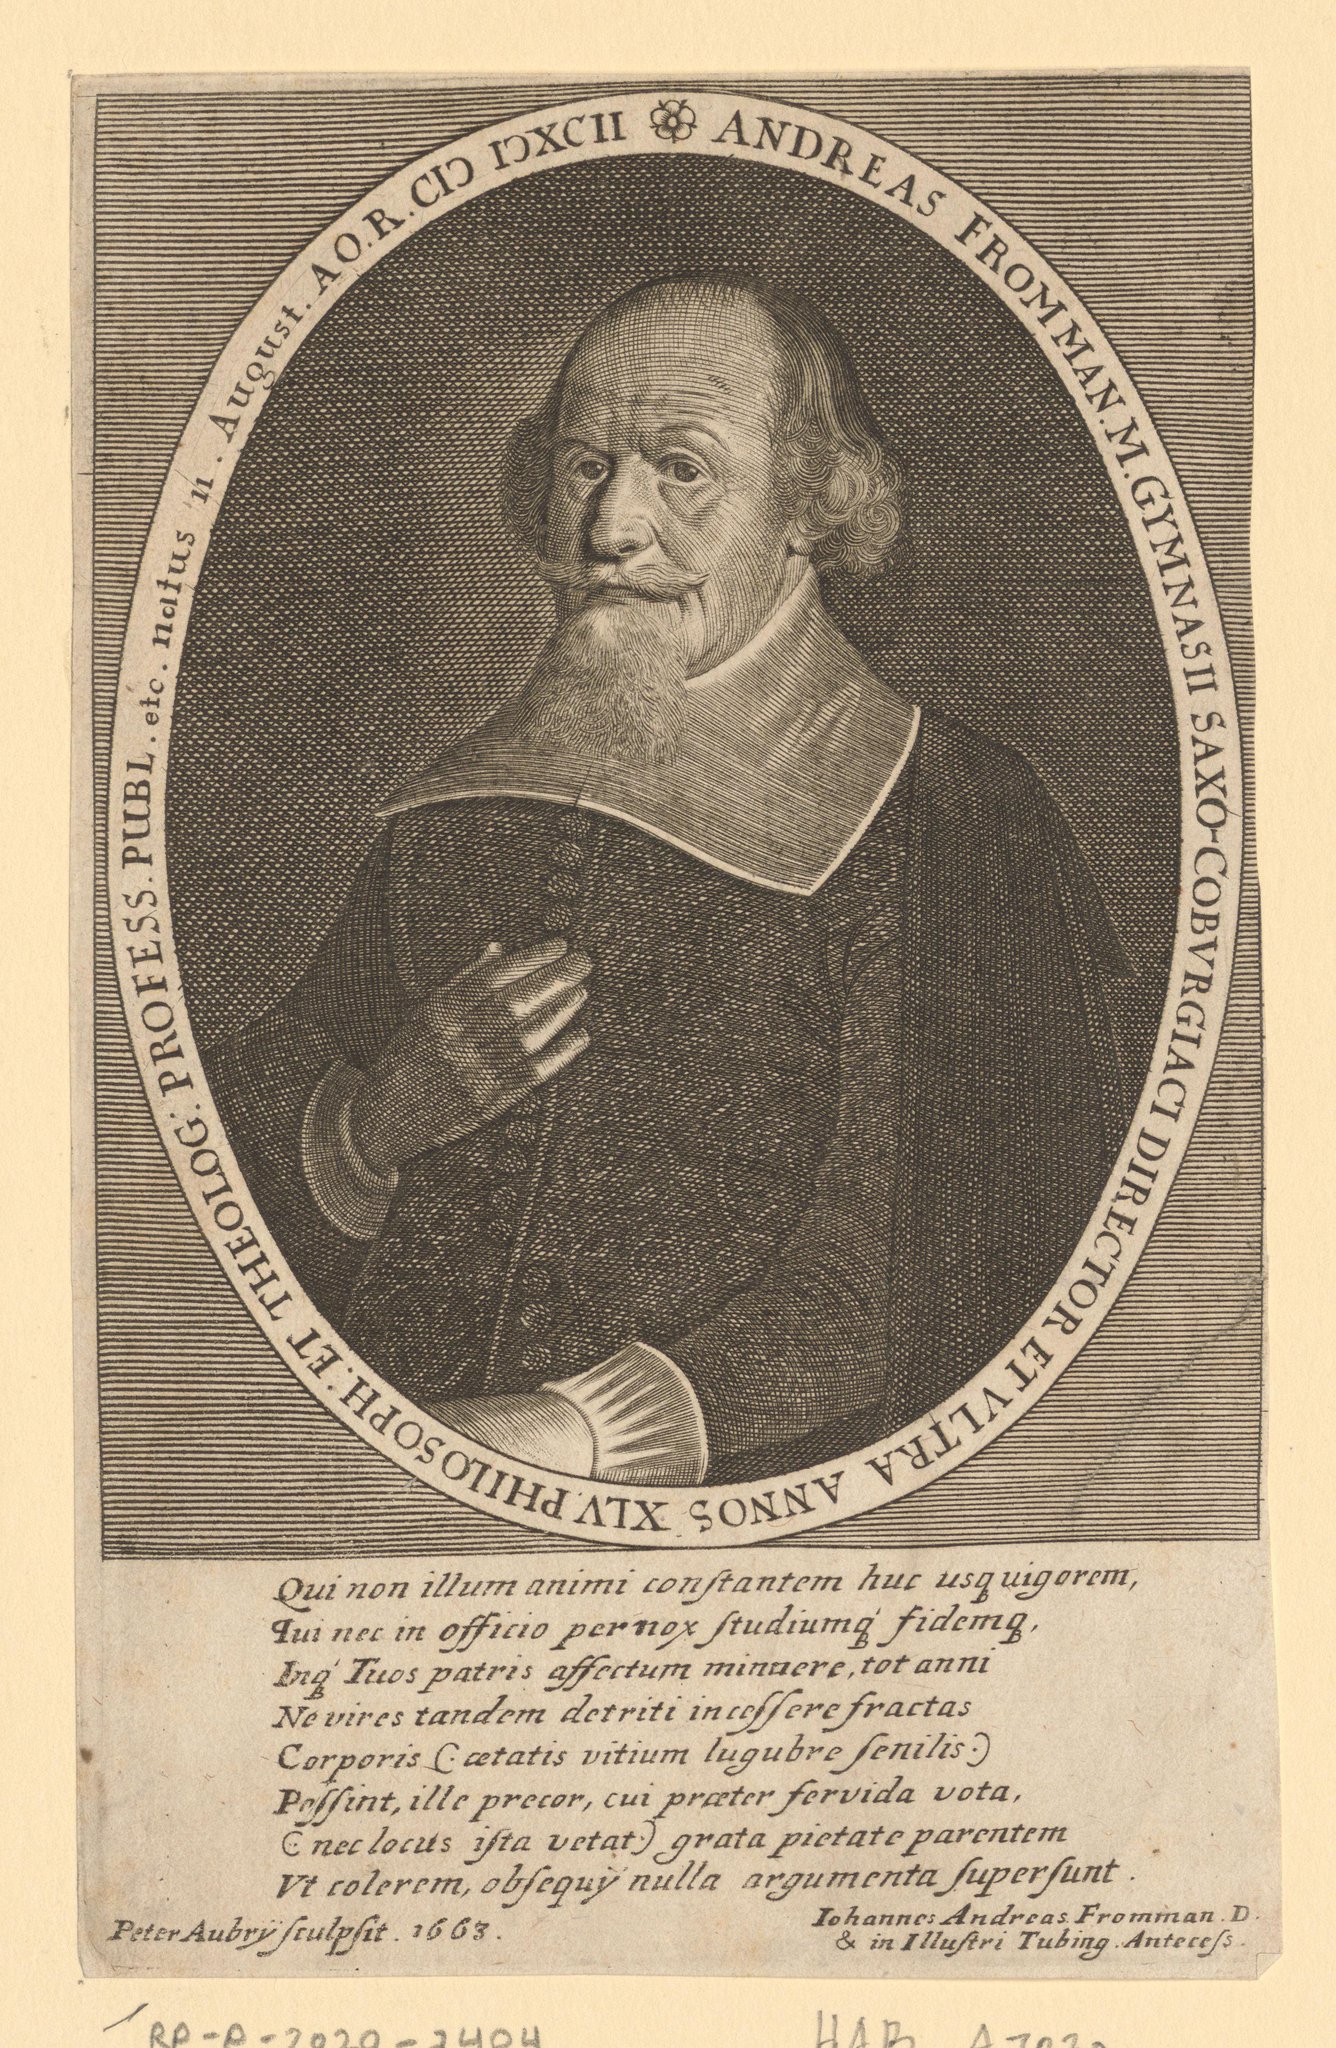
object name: print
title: Portret van Andreas Frommann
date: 1663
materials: paper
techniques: engraving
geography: germany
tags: historical persons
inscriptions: date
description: Met achtregelig onderschrift in het Latijn onder het portret.